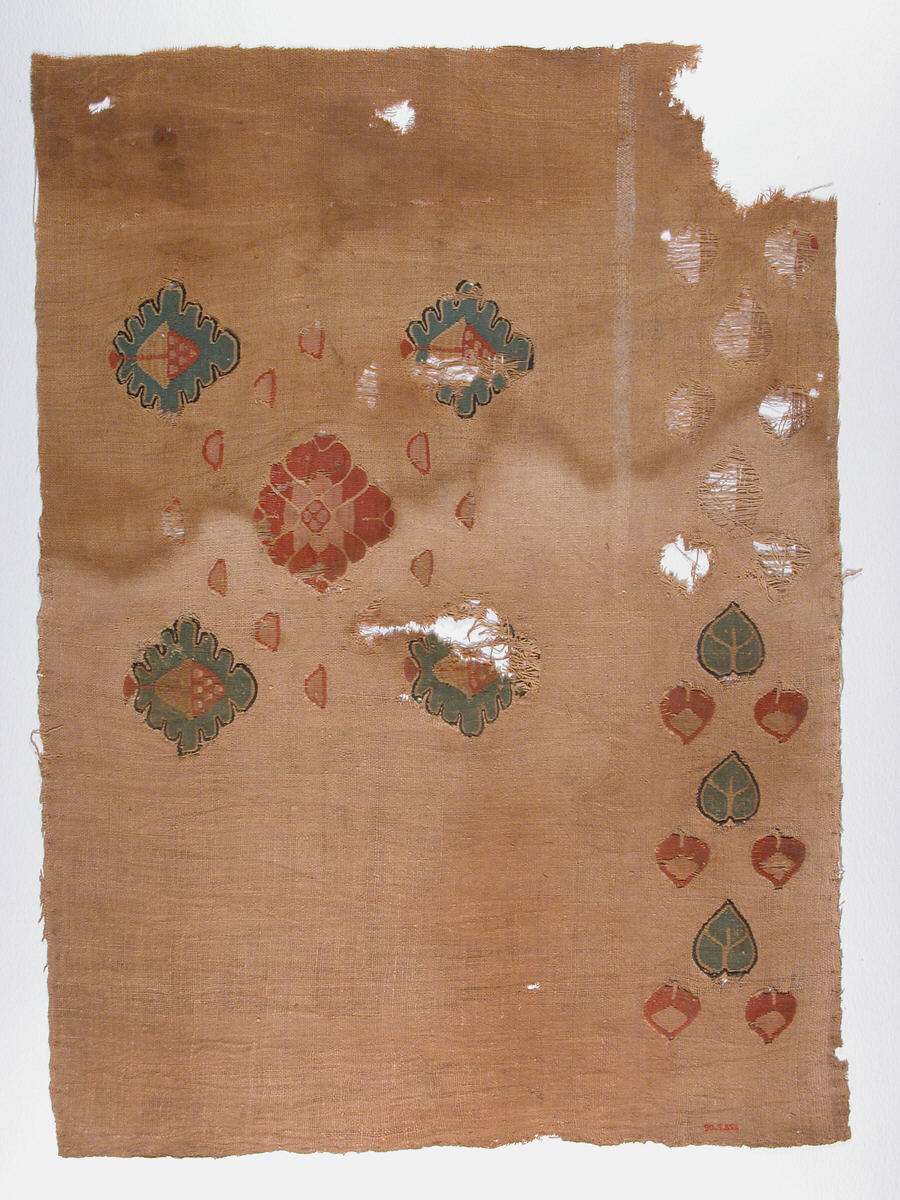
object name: textile fragment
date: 401-500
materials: linen, wool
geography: egypt